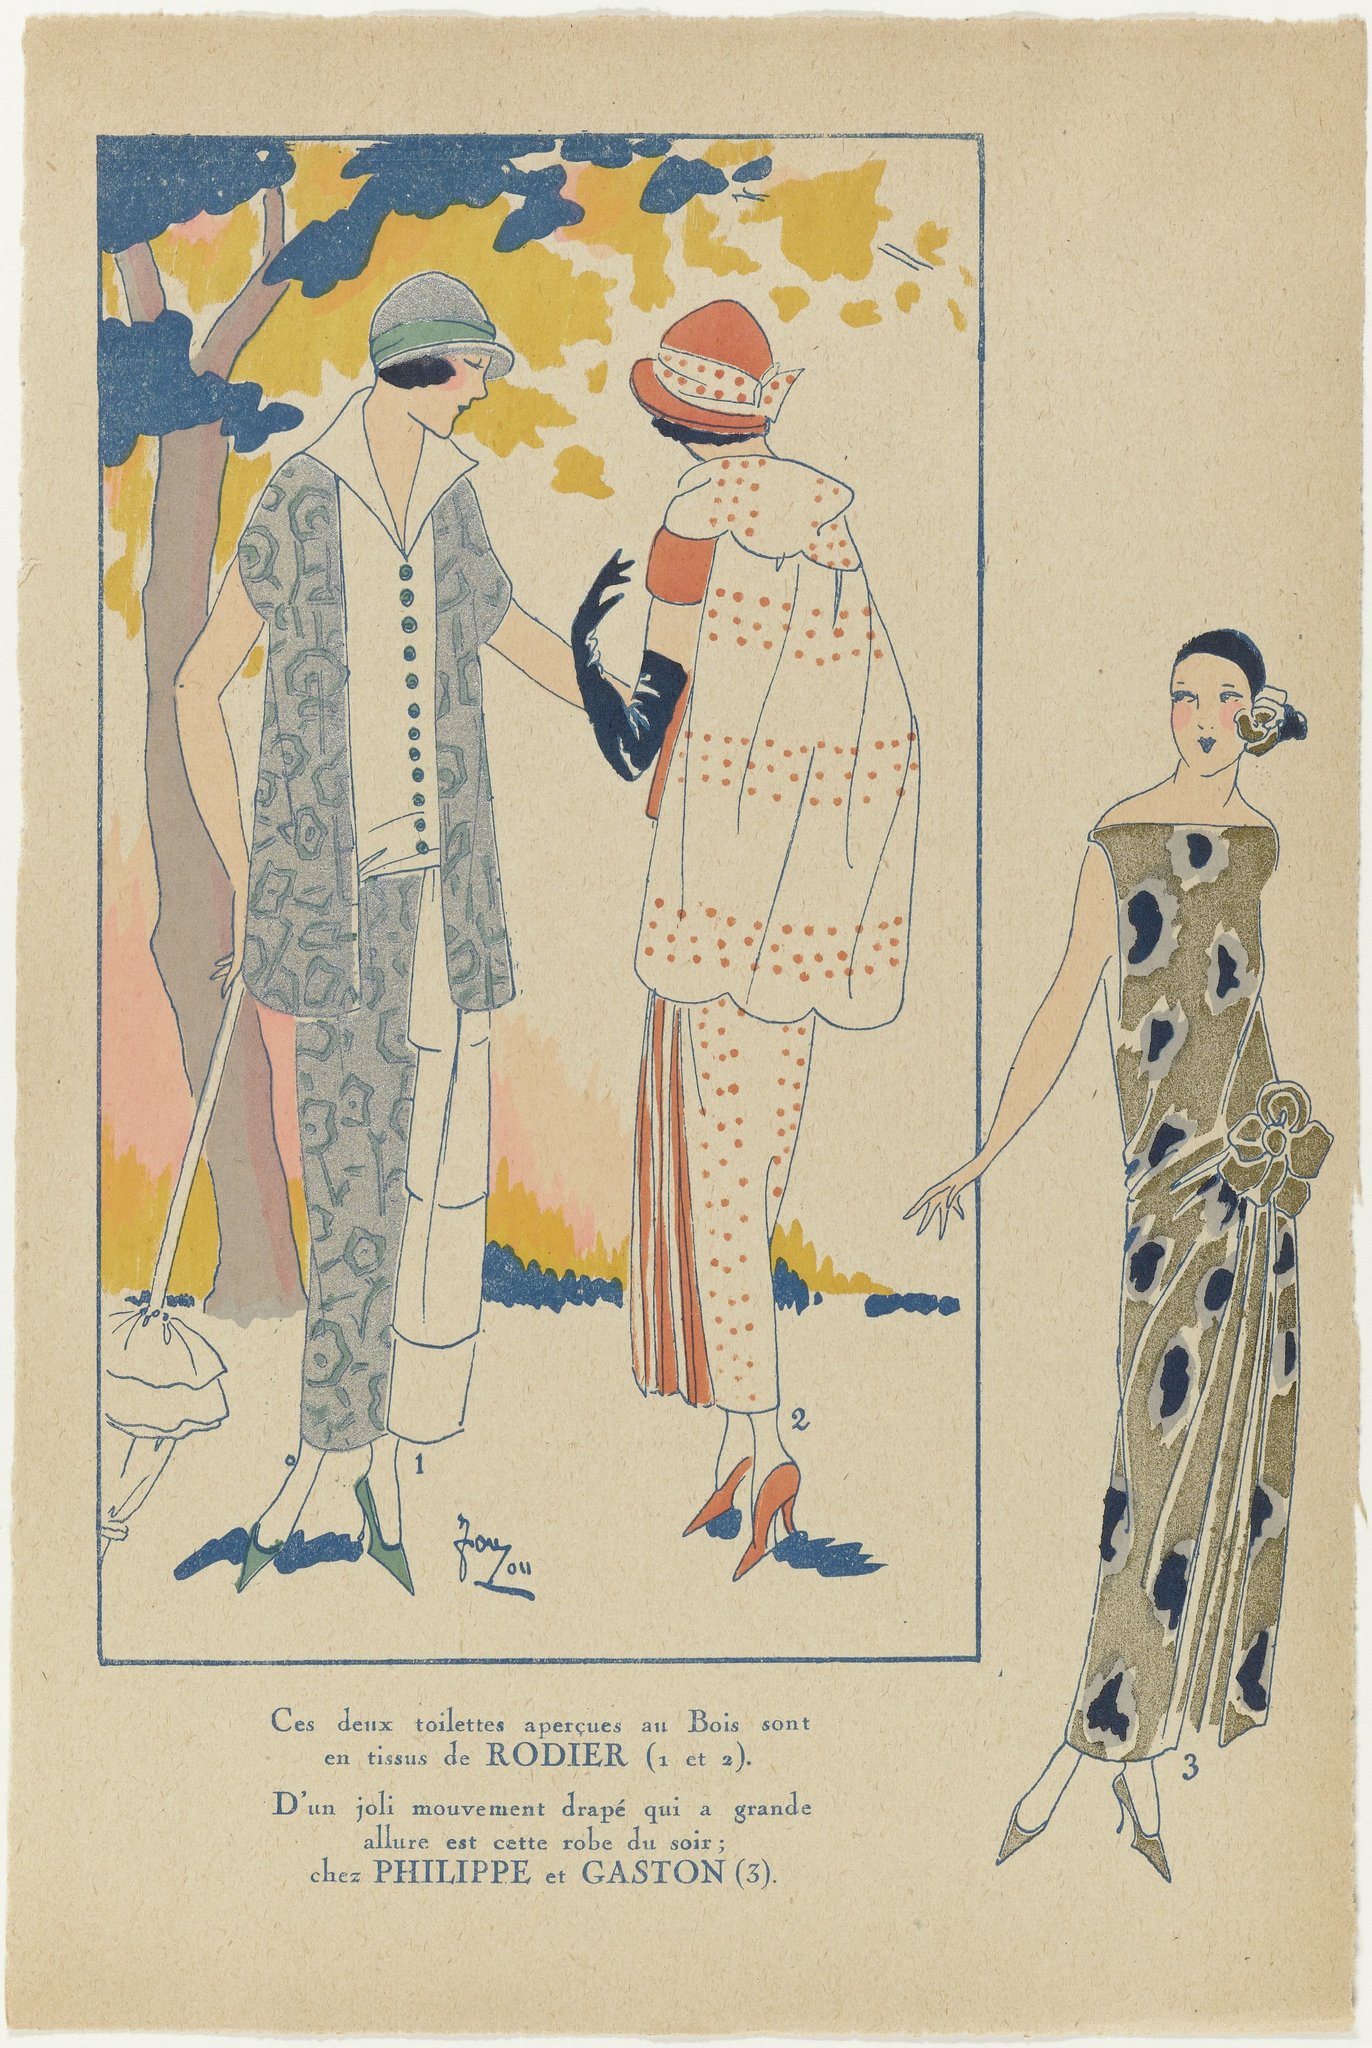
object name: fashion print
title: Très Parisien, 1923, No 6: Ces deux toilettes aperçues au Bois.....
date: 1923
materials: paper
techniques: hand coloring, letterpress printing, lithography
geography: paris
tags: dress, gown: evening dress (+ women's clothes), walking-stick, staff, cane (+ women's clothes), dress, gown: walking dress (+ women's clothes), cape (+ women's clothes), fashion plates, skirt (+ women's clothes), gloves, mittens, etc. (+ women's clothes)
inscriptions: caption: ‘Ces deux toilettes aperçues au Bois sont en tissus de RODIER (1 et 2). D'un joli mouvement drapé qui a grande allure est cette robe du soir; chez PHILIPPE et GASTON (3).’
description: Nummer 1 en 2: twee ensembles, gemaakt van stoffen van Rodier. Accessoires: cloches (pothoeden), lange handschoen, wandelstok (parasol), pumps. Nummer 3: een gedrapeerde avondjurk van Philippe et Gaston. Prent uit het modetijdschrift Très Parisien (1920-1936).